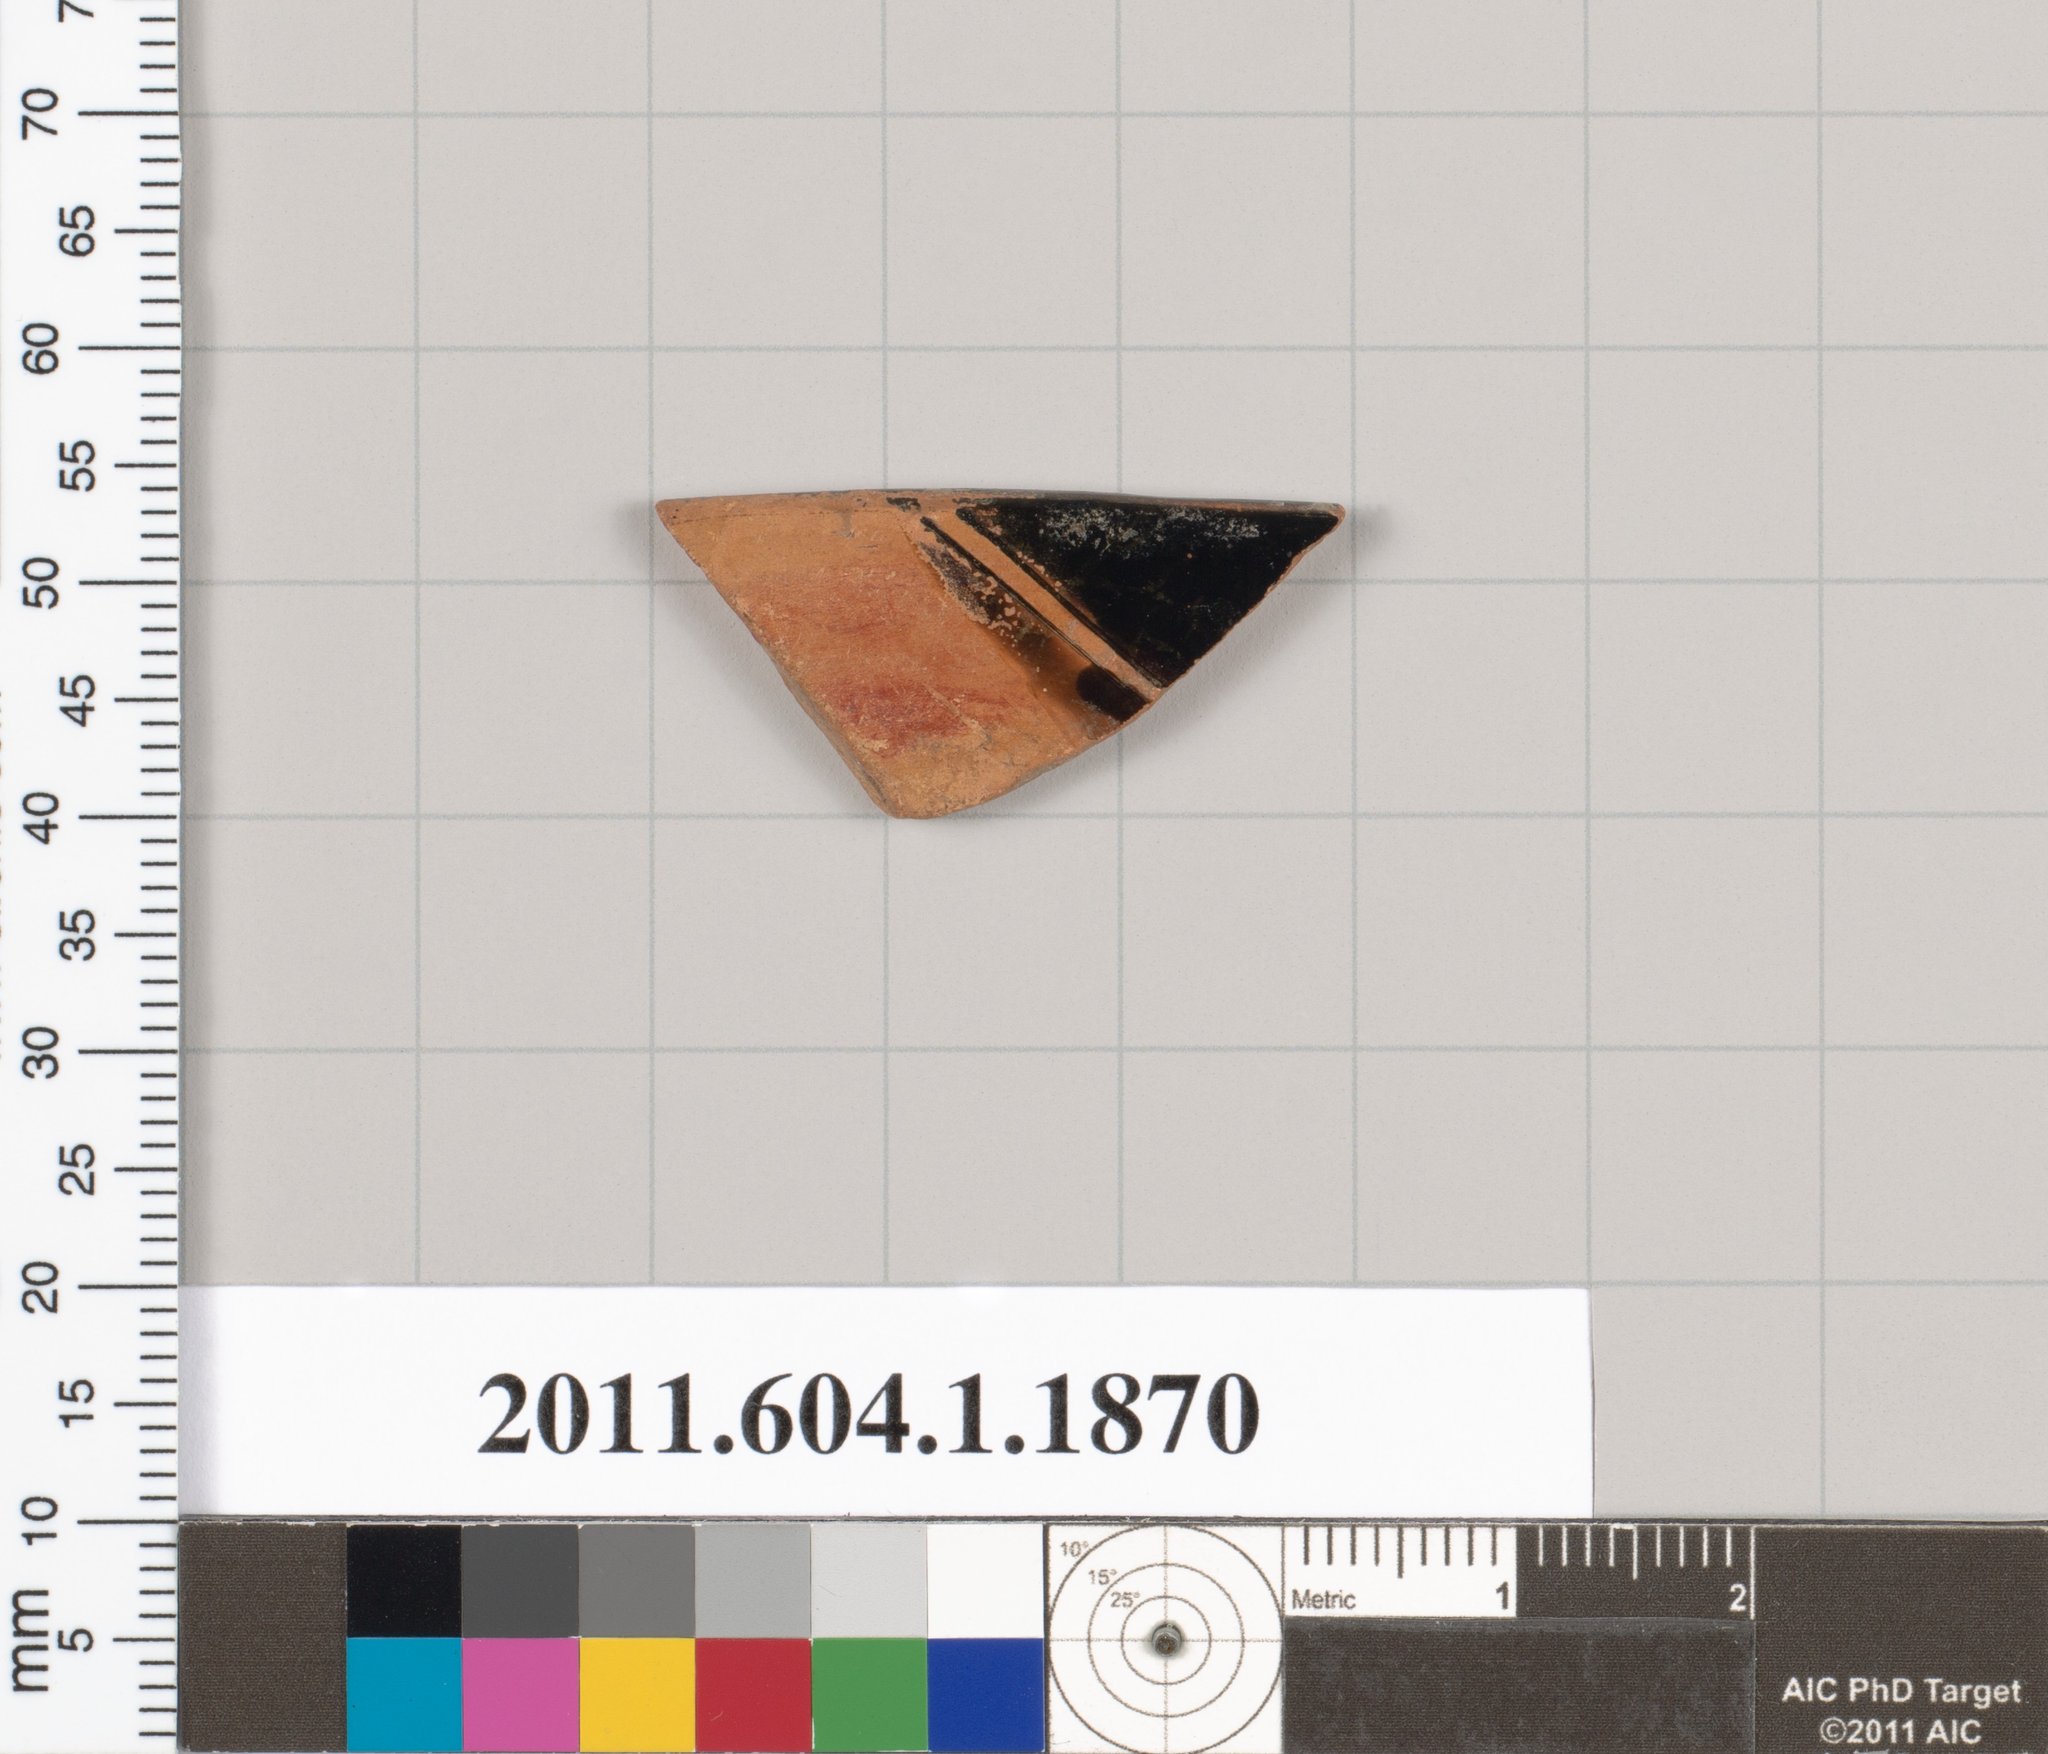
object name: kylix fragment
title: Terracotta rim fragment of a kylix (drinking cup)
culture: greek, attic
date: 500-401 BCE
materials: terracotta